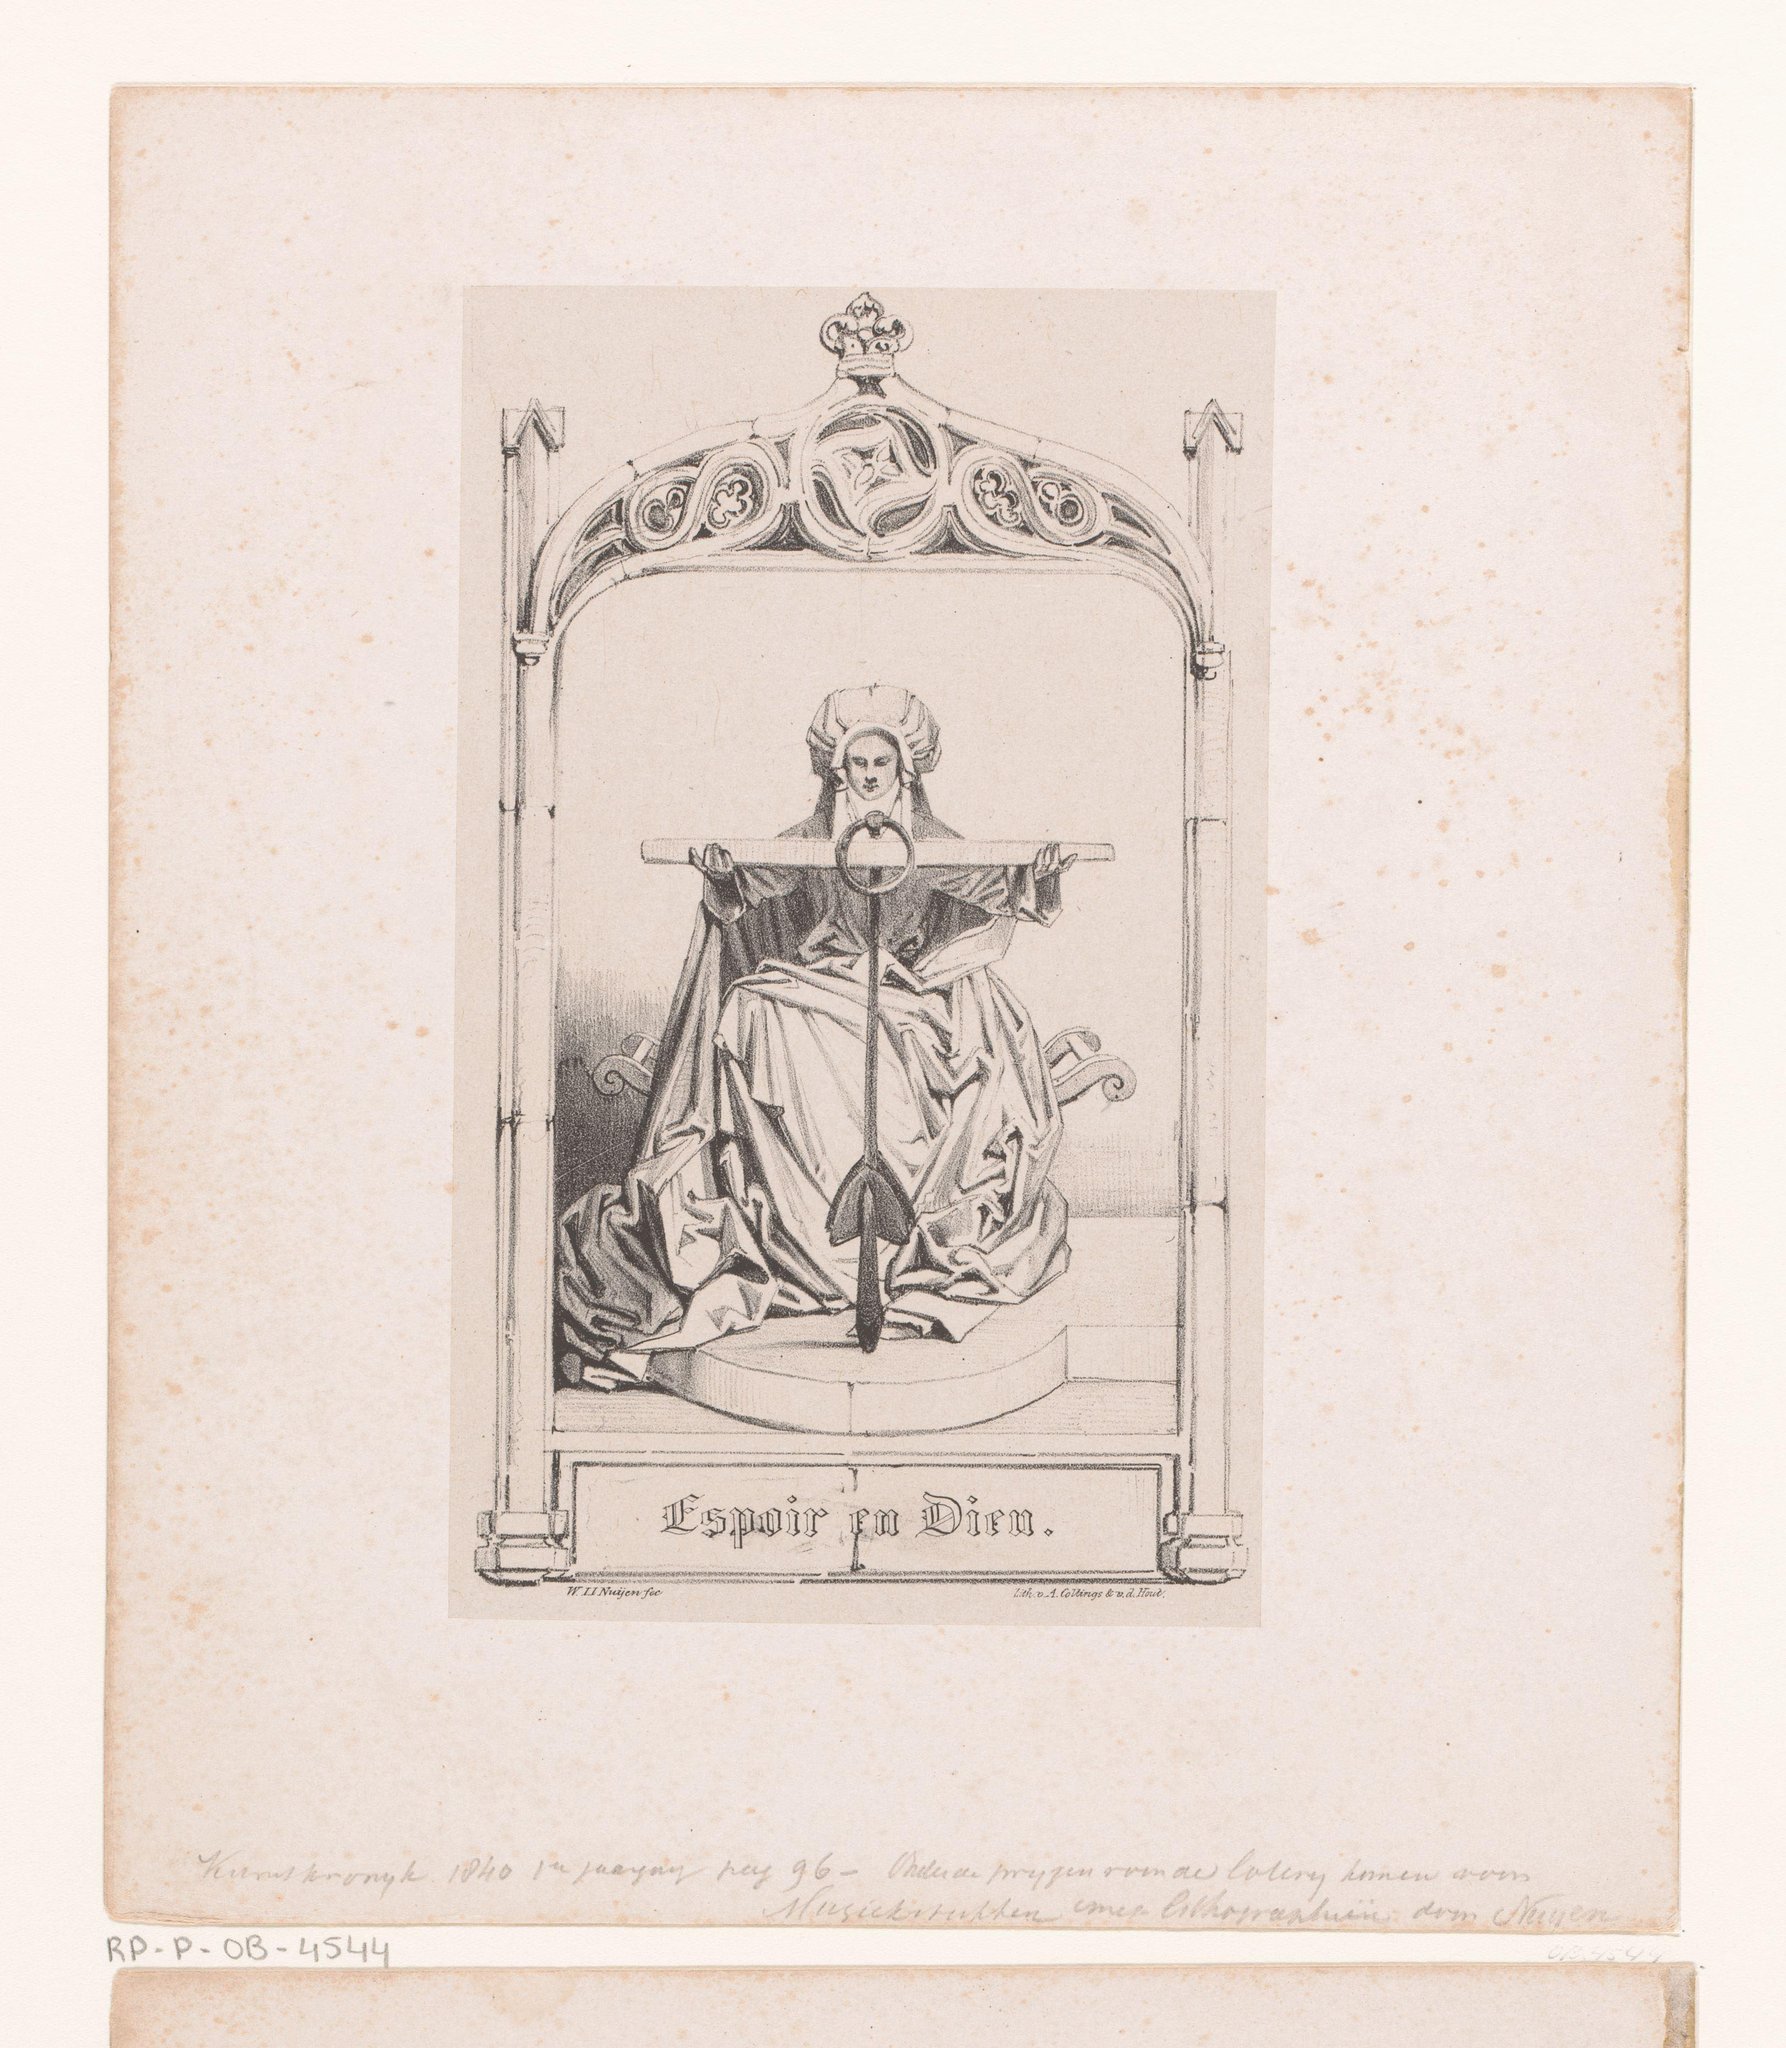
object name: print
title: Gezeten vrouw die een kruis ophoudt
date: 1823-1839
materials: paper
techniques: lithograph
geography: rotterdam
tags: faith, 'fides'; 'fede', 'fede catholica', 'fede christiana', 'fede christiana catholica' (ripa) ~ one of the three theological virtues, hope, 'spes'; 'speranza divina e certa' (ripa) ~ one of the three theological virtues, the cross ~ symbols of christ, parts of ship's exterior: anchor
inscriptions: collector's mark: Lugt 2228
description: Een vrouw gezeten op een bank houdt een kruisanker op. Rondom een architecturale omlijsting.